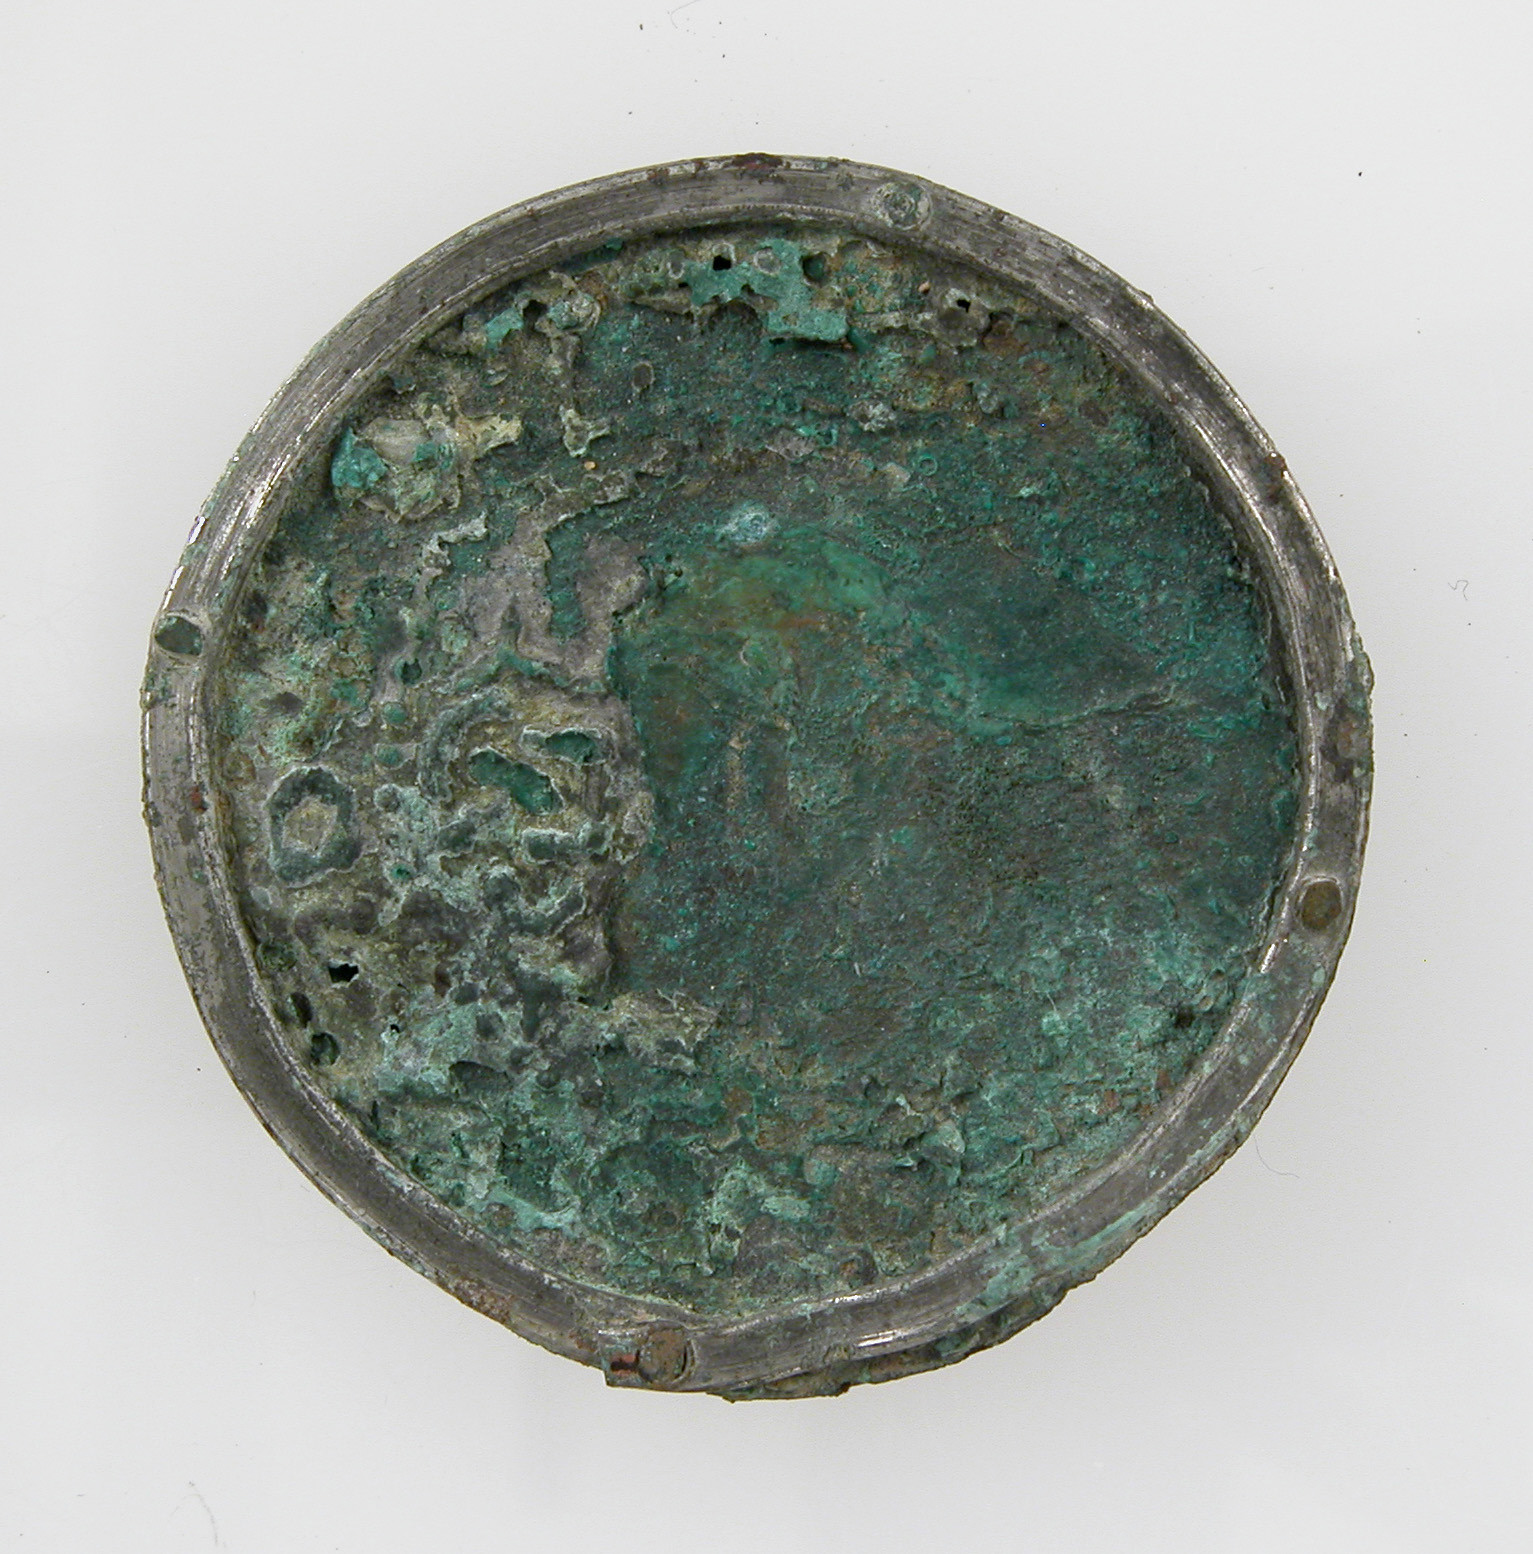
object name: bracteate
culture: frankish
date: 501-700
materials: copper alloy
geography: germany